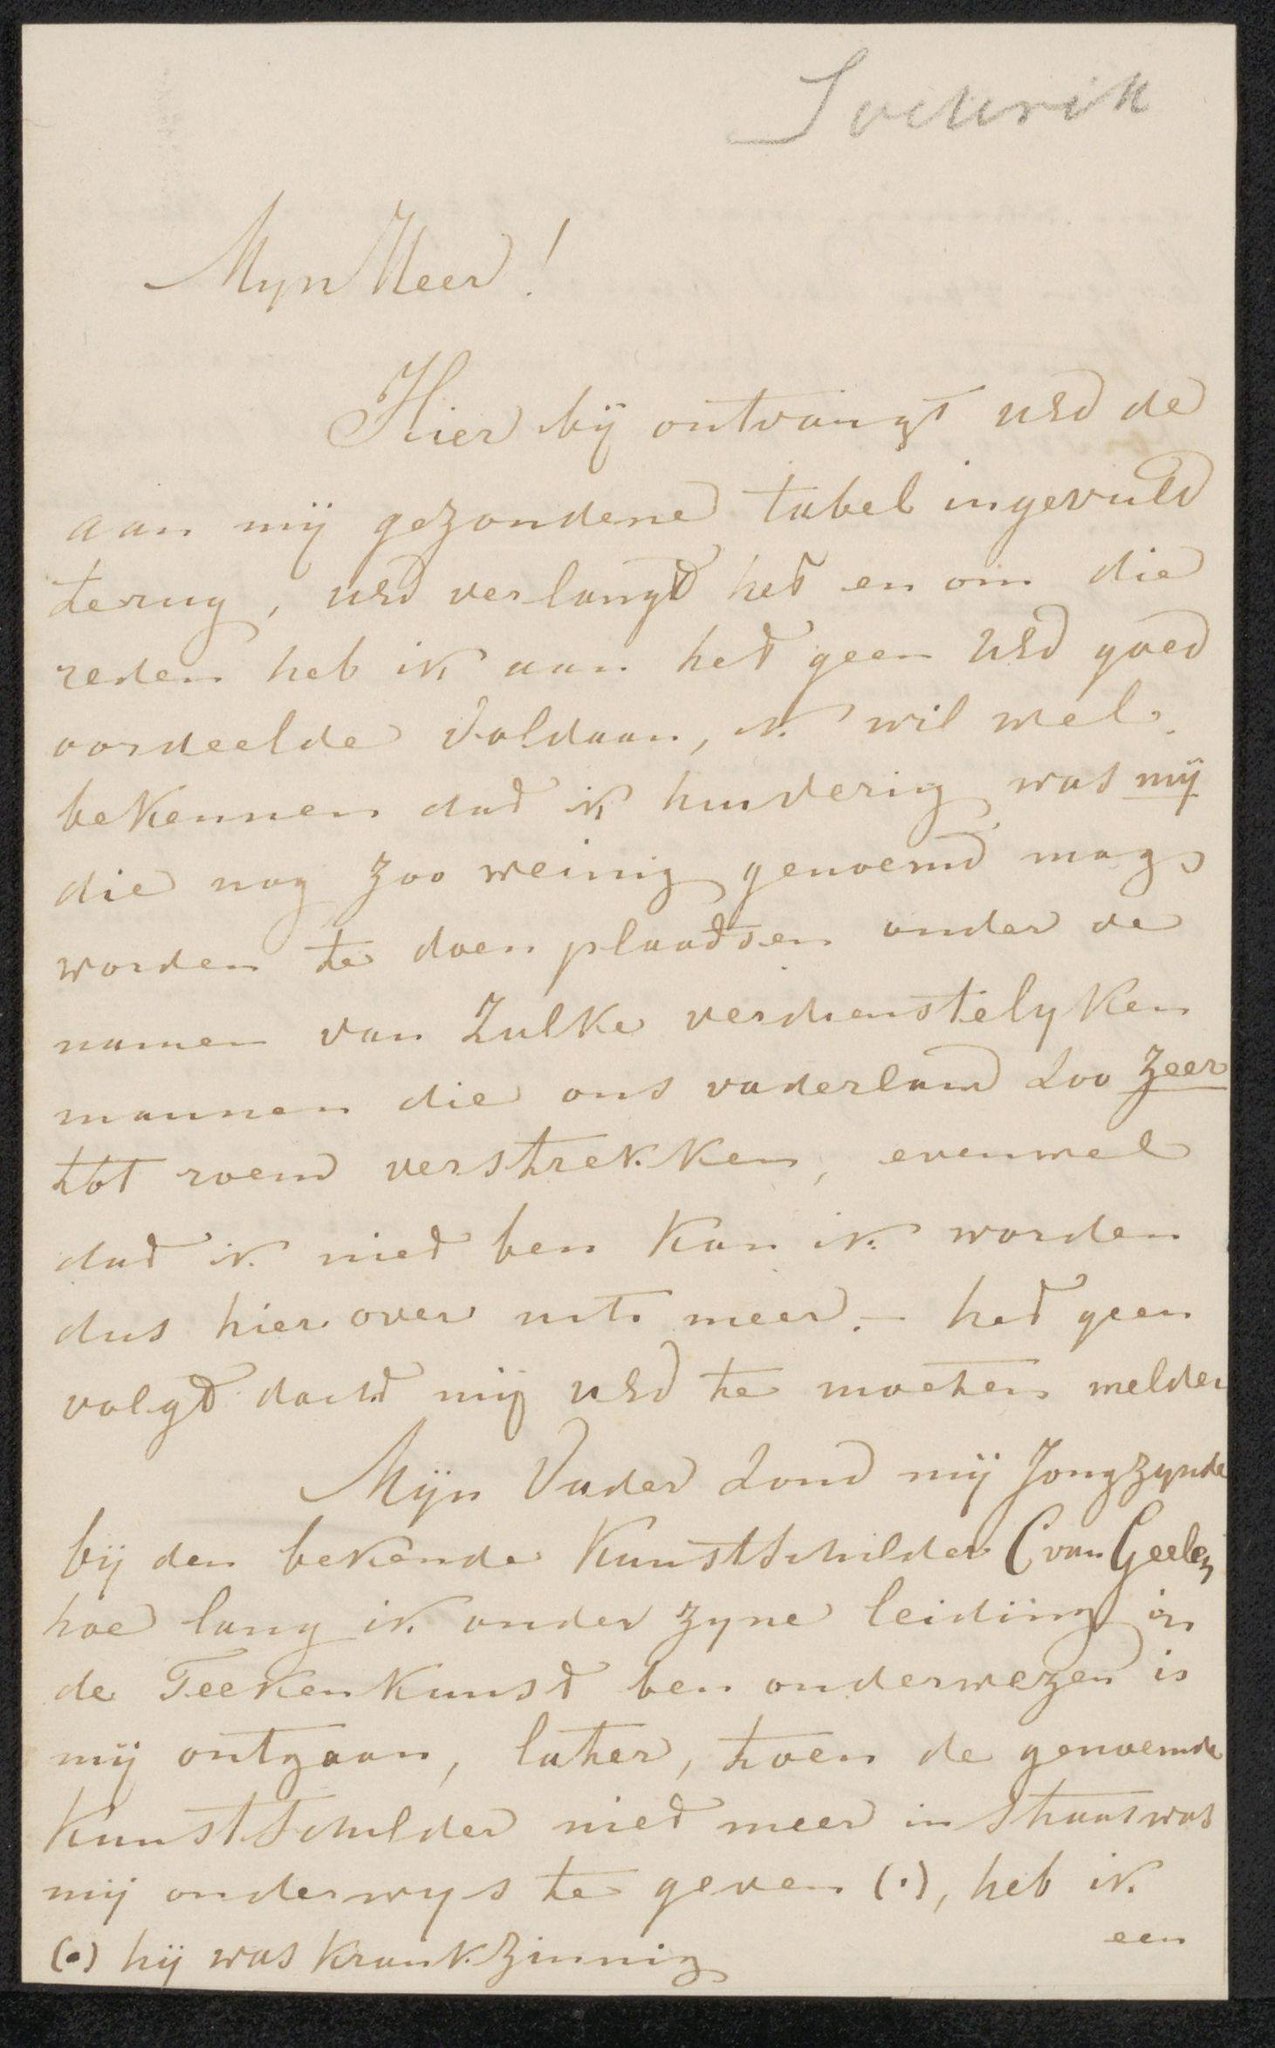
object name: letter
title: Brief aan Johannes Immerzeel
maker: theodoor soeterik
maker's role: draughtsman, print maker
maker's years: 1810-1883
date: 1840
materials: ink, paper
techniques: pen, writing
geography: utrecht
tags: johannes immerzeel, the graphic arts, education, tuition of the artist (in general), painting (including book-illumination, miniature-painting)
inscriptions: collector's mark: ‘RPK’